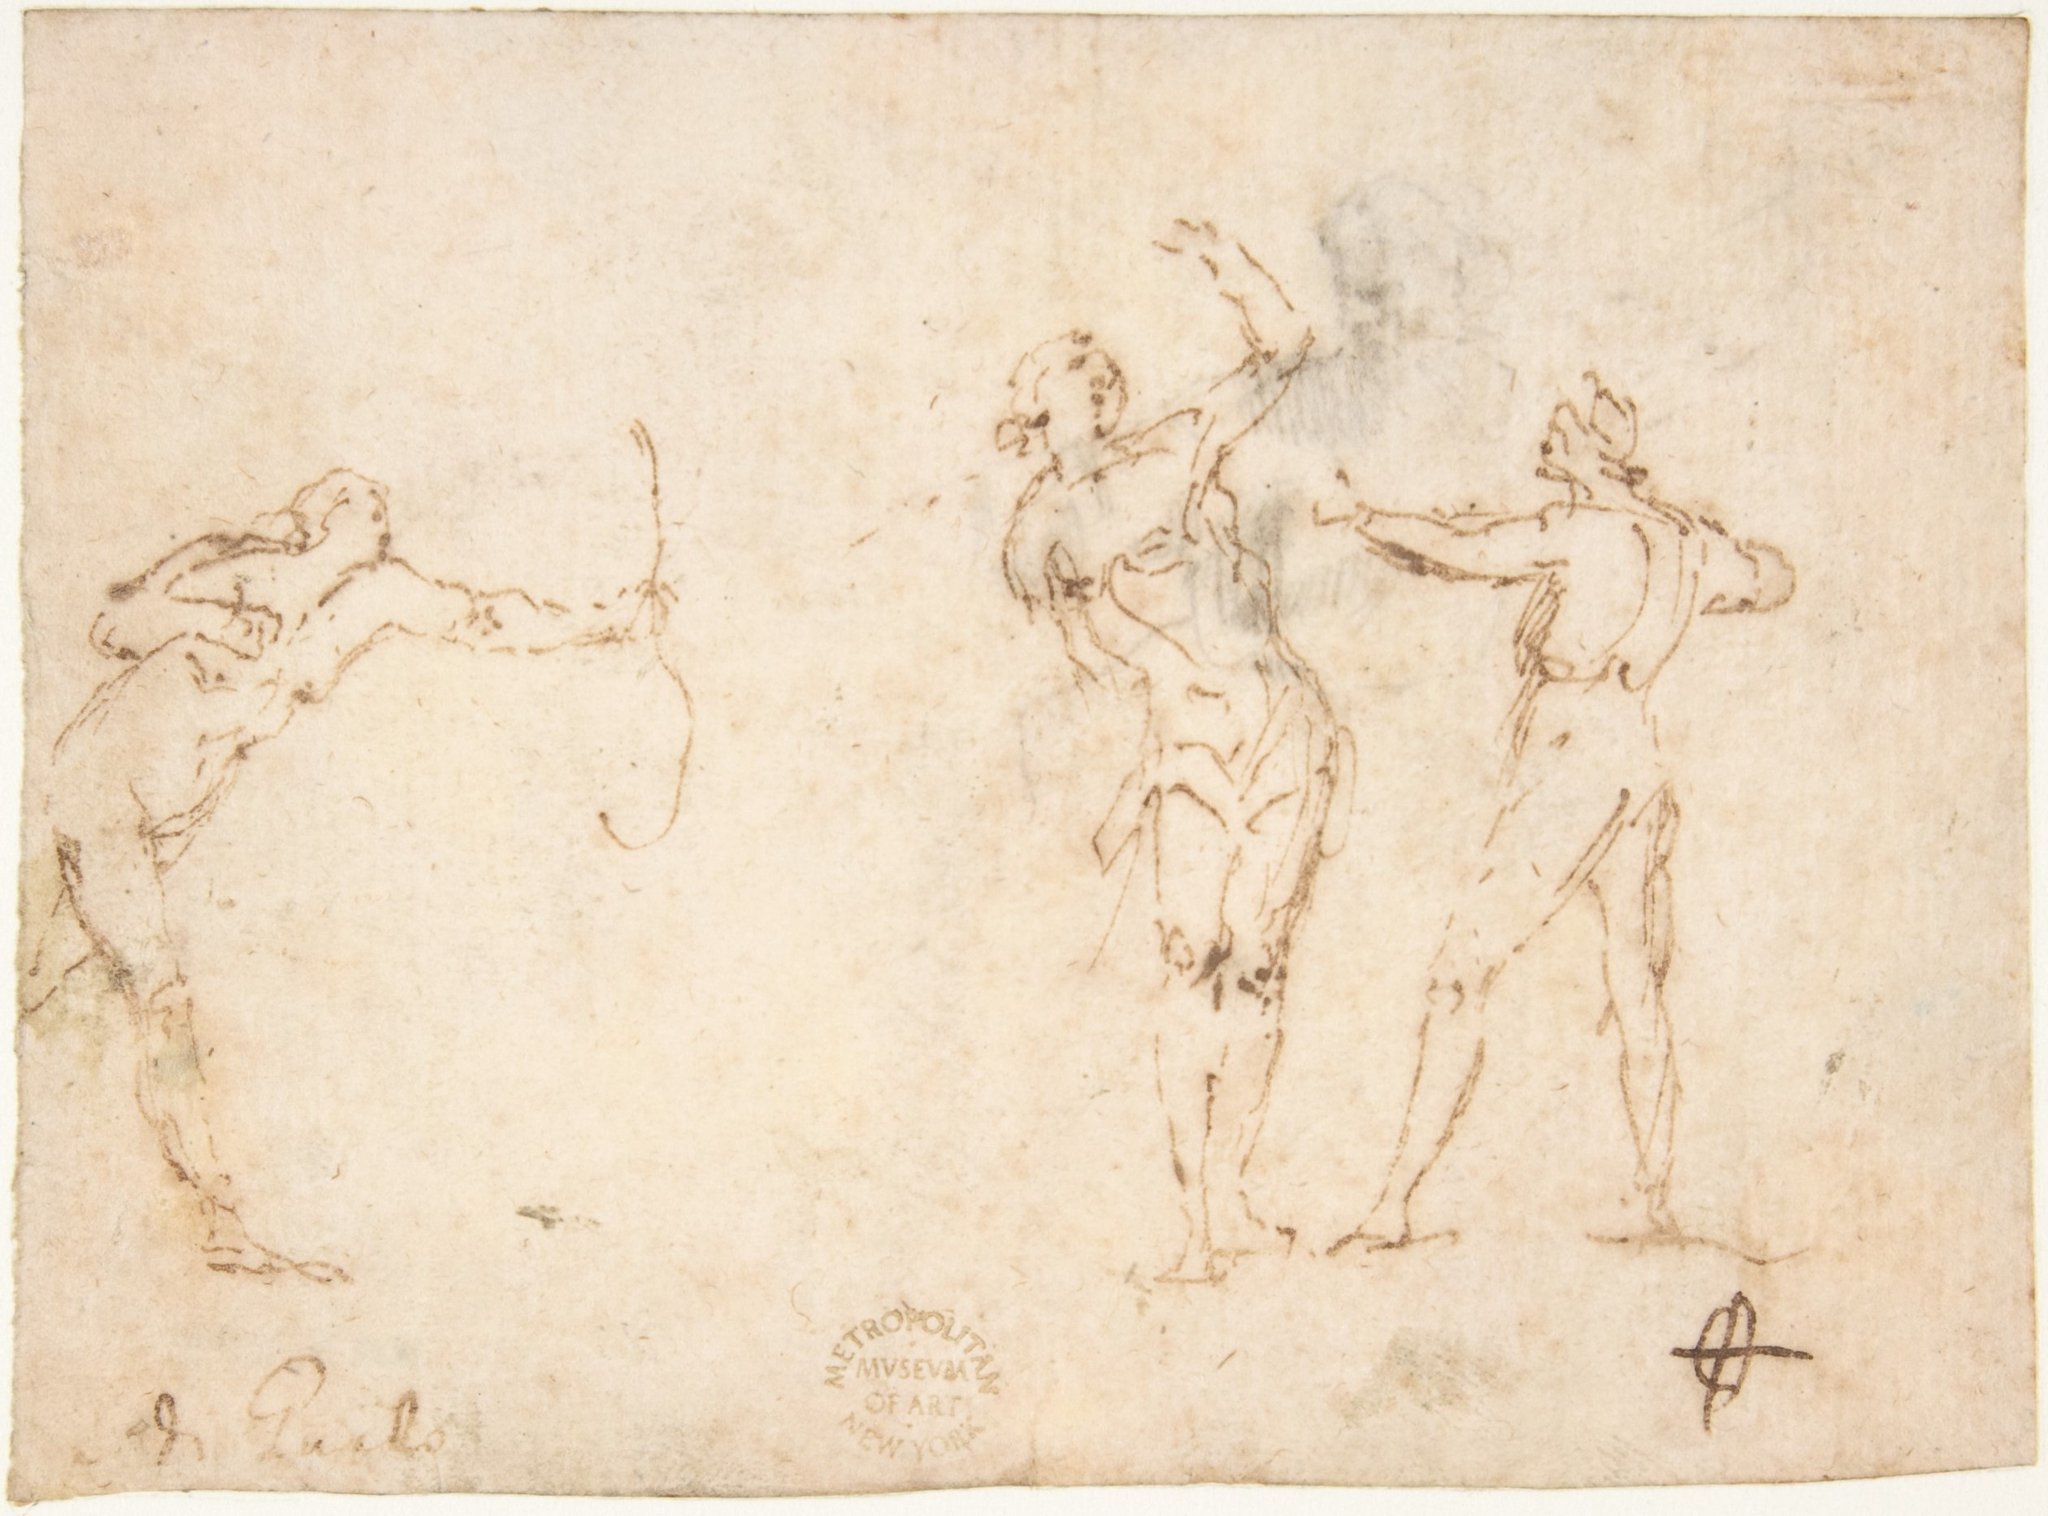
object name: drawing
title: The Martyrdom of Saint Sebastian (recto); Bearded Old Man Blessing Seen in Half-length (verso)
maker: francesco allegrini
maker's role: artist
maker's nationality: italian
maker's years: 1615-1679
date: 1624-1663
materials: chalk, ink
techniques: pen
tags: men,saints